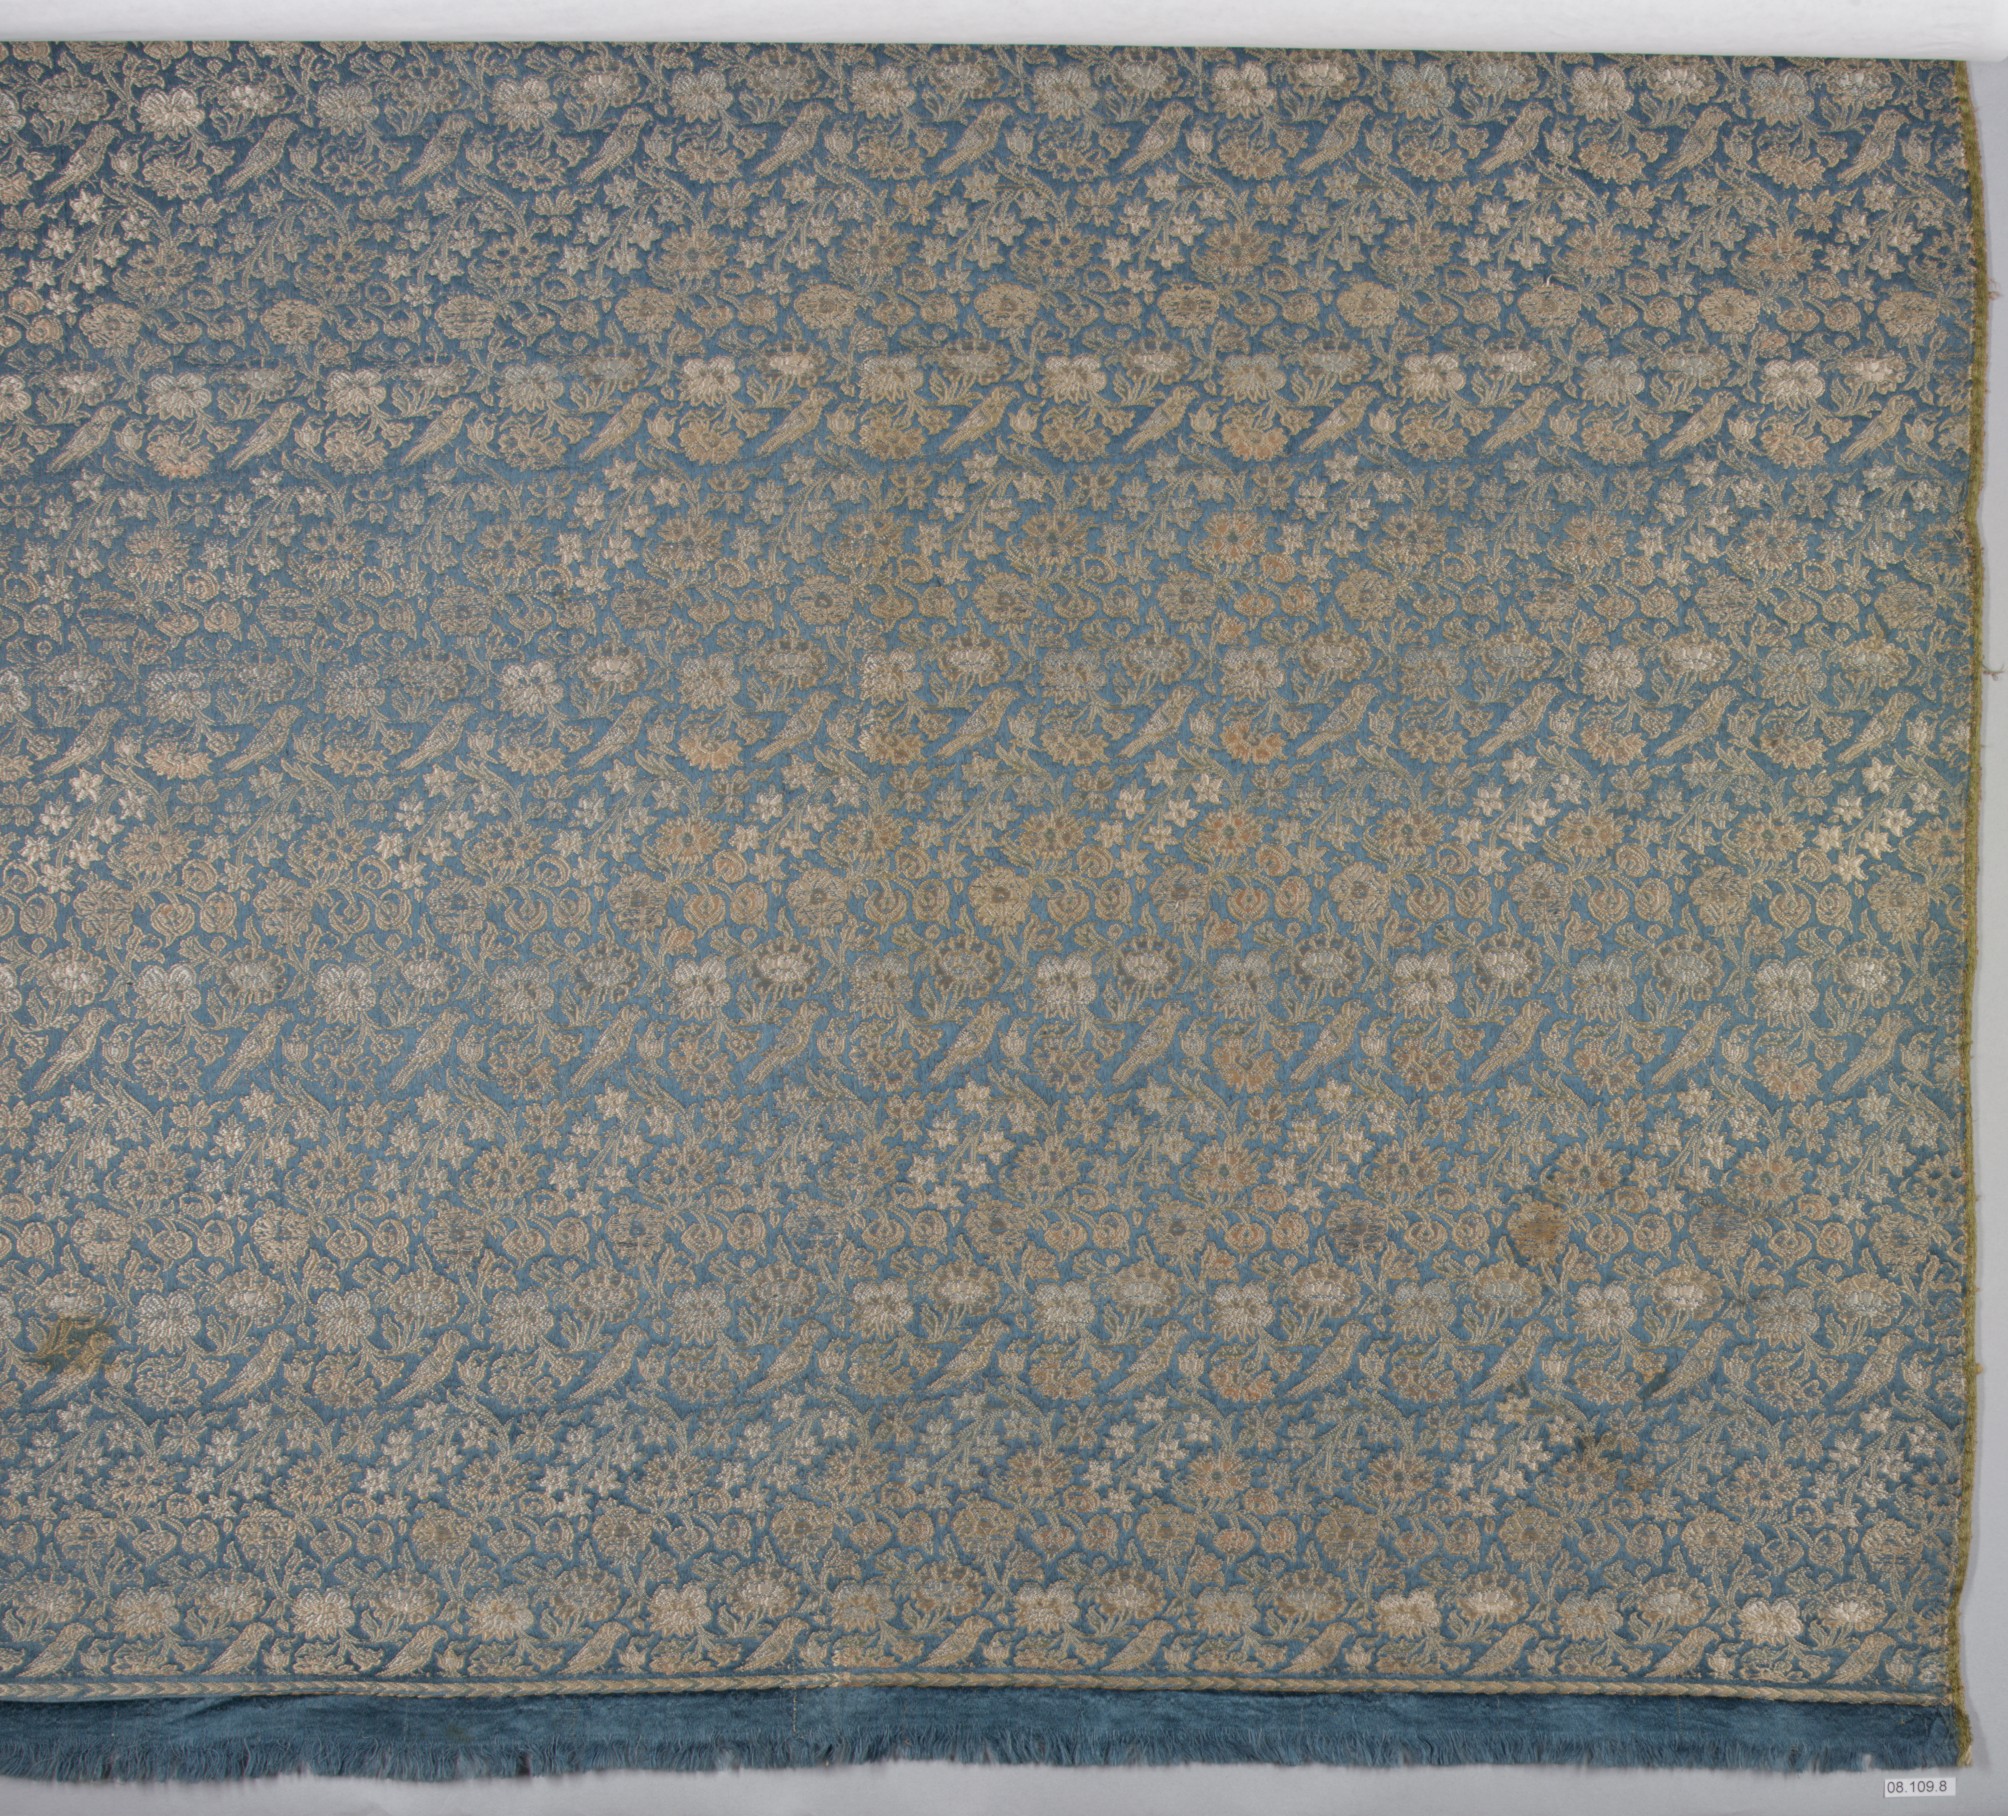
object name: textile fragment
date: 1501-1600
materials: silk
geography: iran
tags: birds,flowers